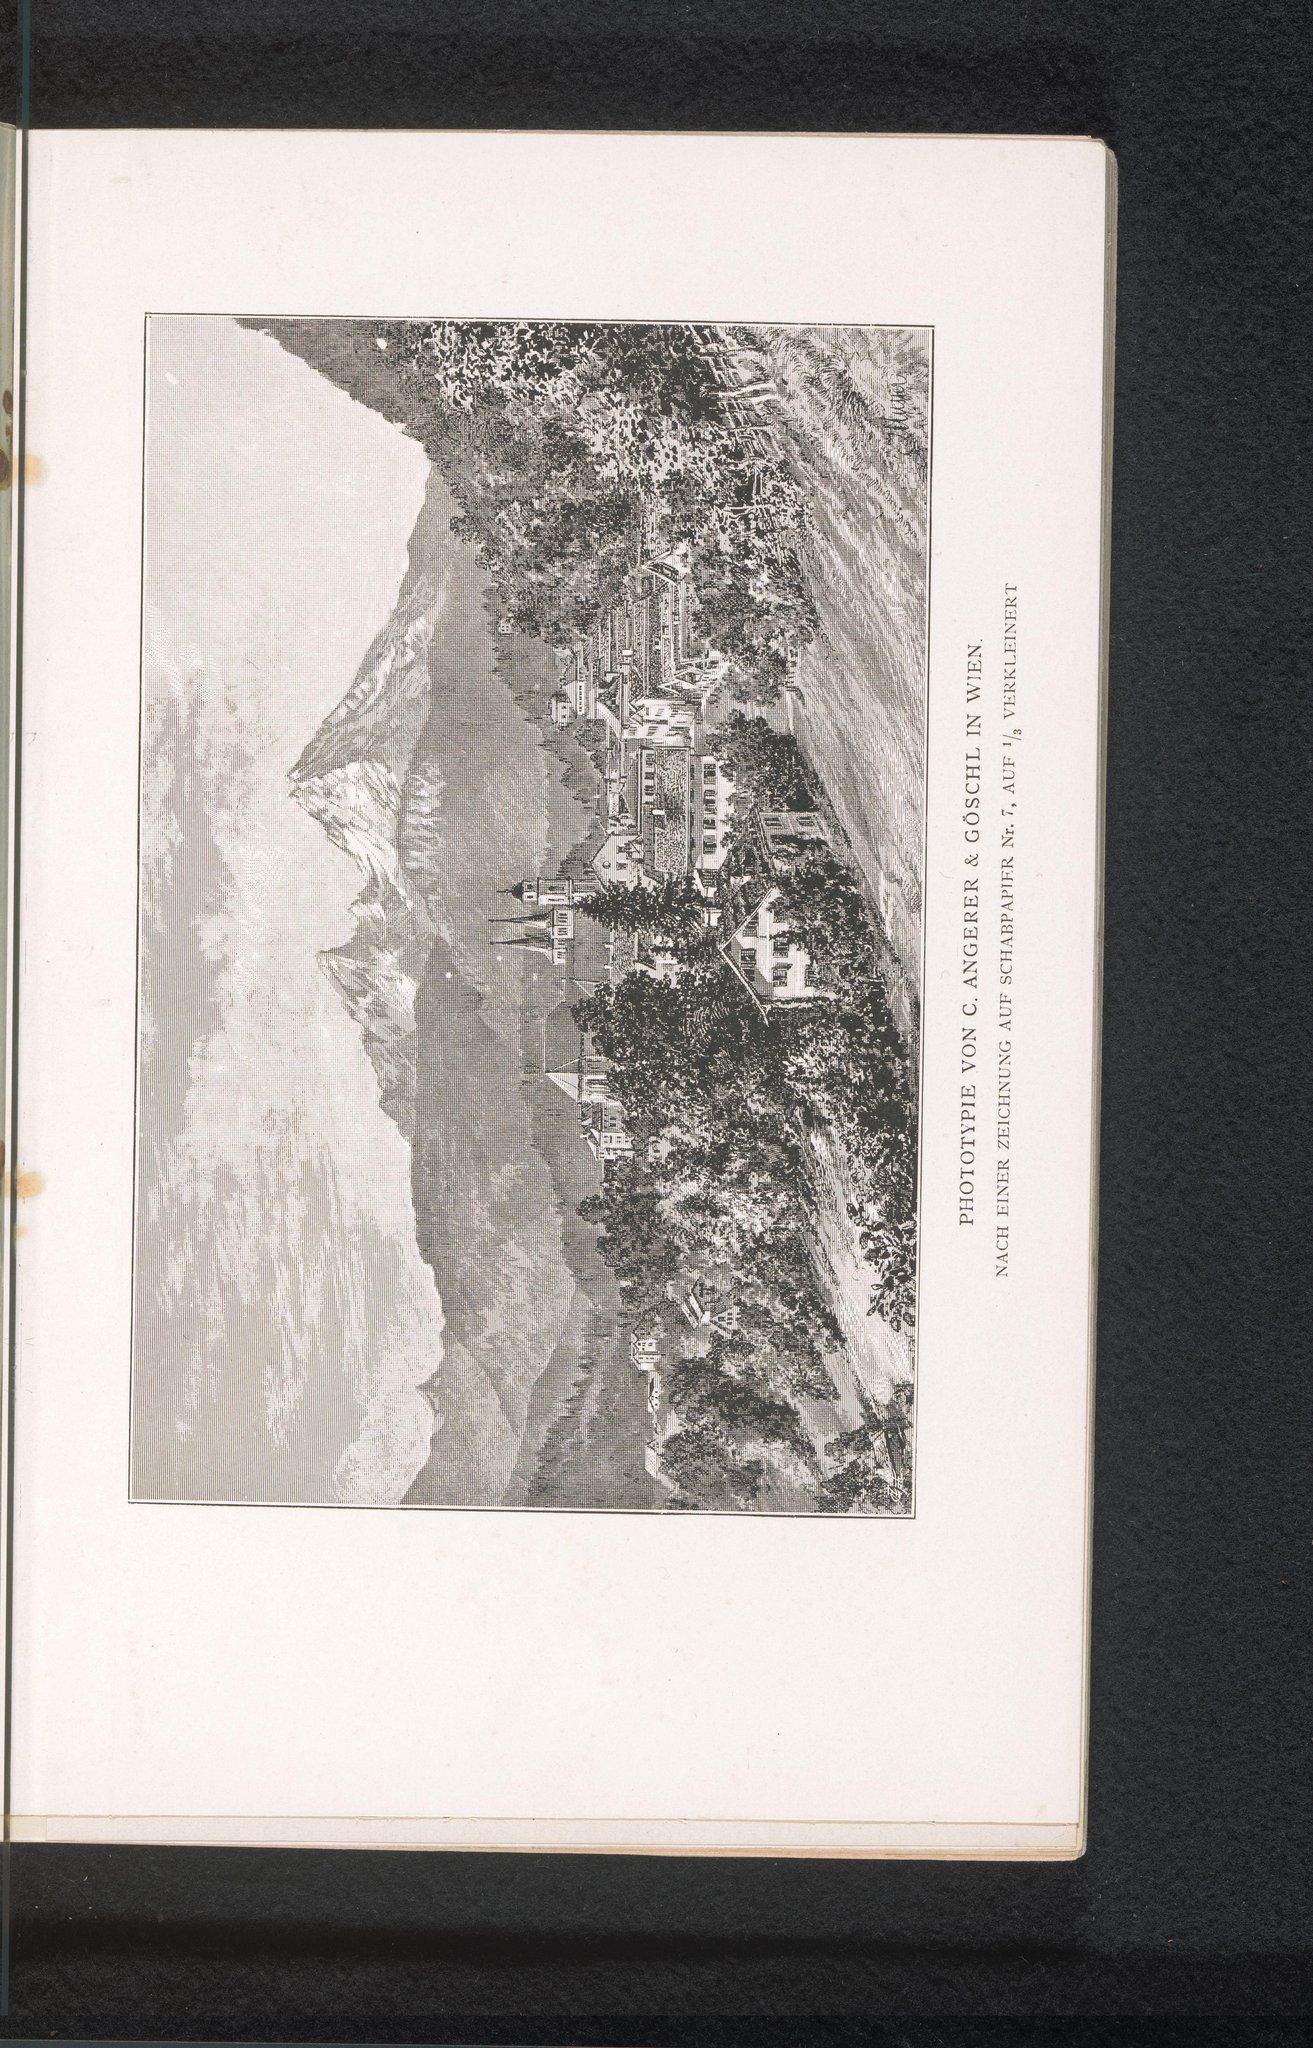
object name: page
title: Reproductie van een tekening met de voorstelling van een dorp in de bergen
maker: Anonymous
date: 1894-1899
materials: paper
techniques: autotype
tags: city-view in general; 'veduta', painting, drawing and the graphic arts, mountains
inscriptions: inscription: ‘nach einer zeichnung auf schabpapier Nr. 7, auf 1/3 verkleinert’